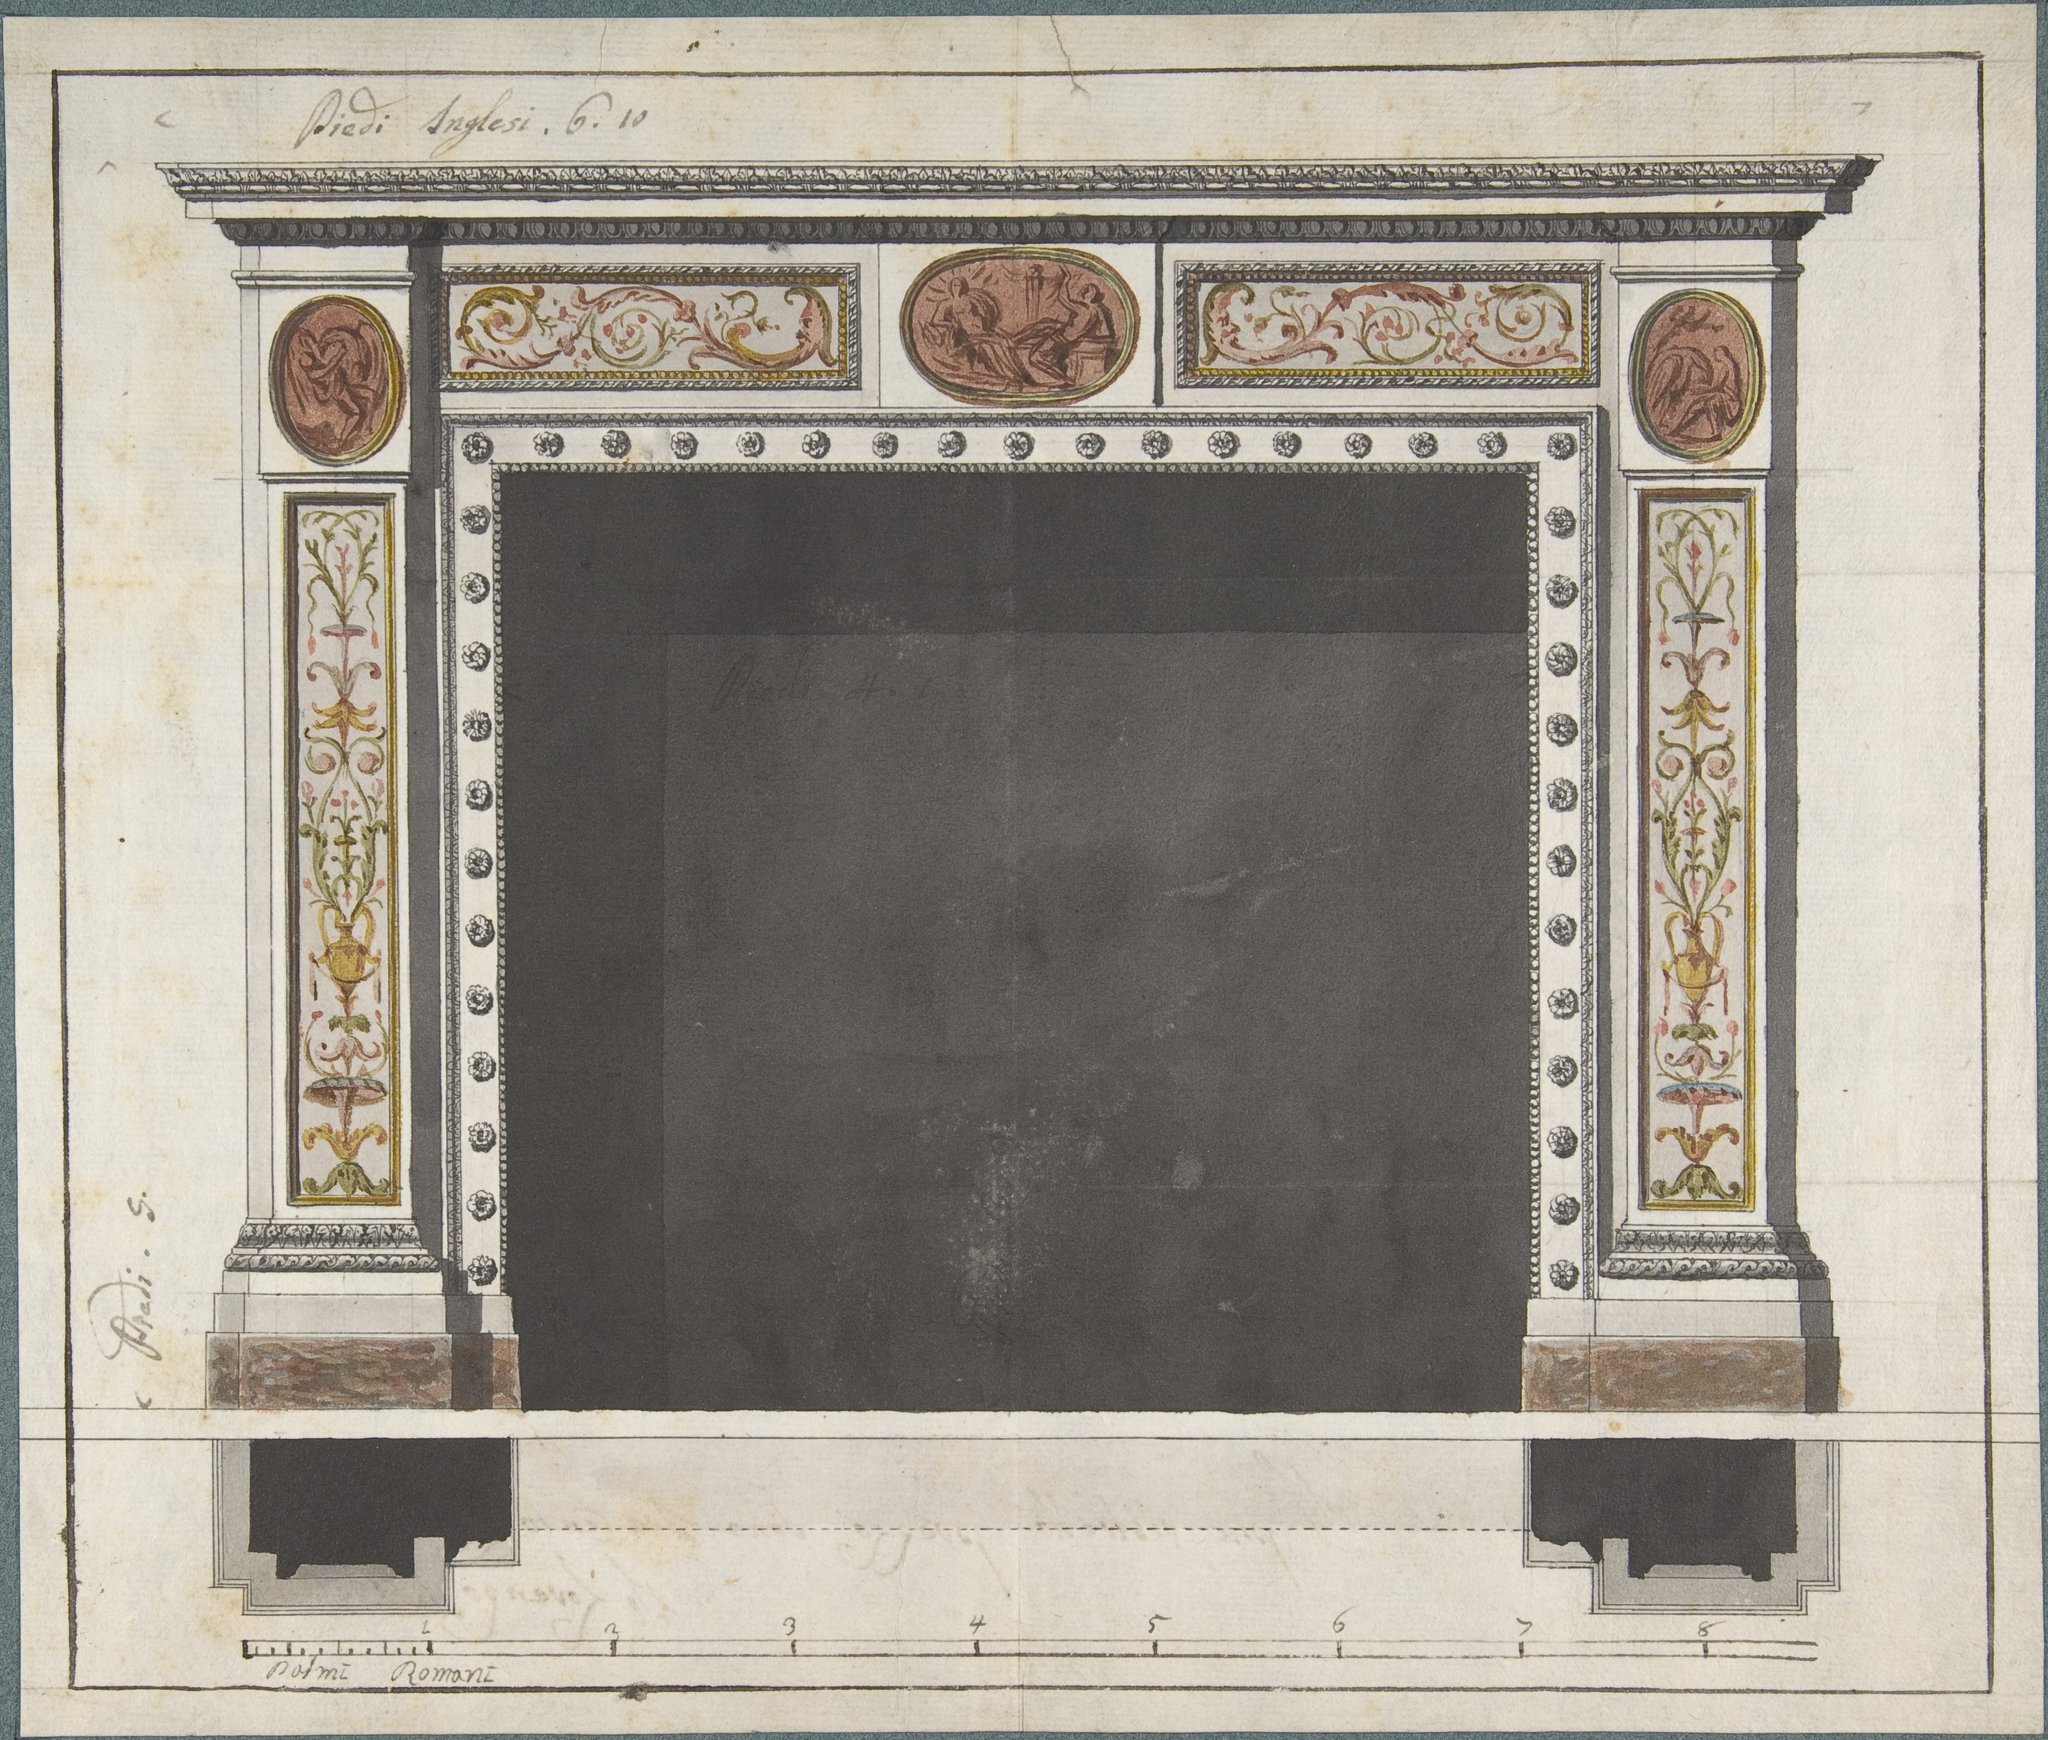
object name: drawing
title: Drawing for a Mantelpiece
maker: anonymous, italian, 18th century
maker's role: artist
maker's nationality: italian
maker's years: 1700-1800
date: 1780-1790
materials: ink, watercolor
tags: fireplaces